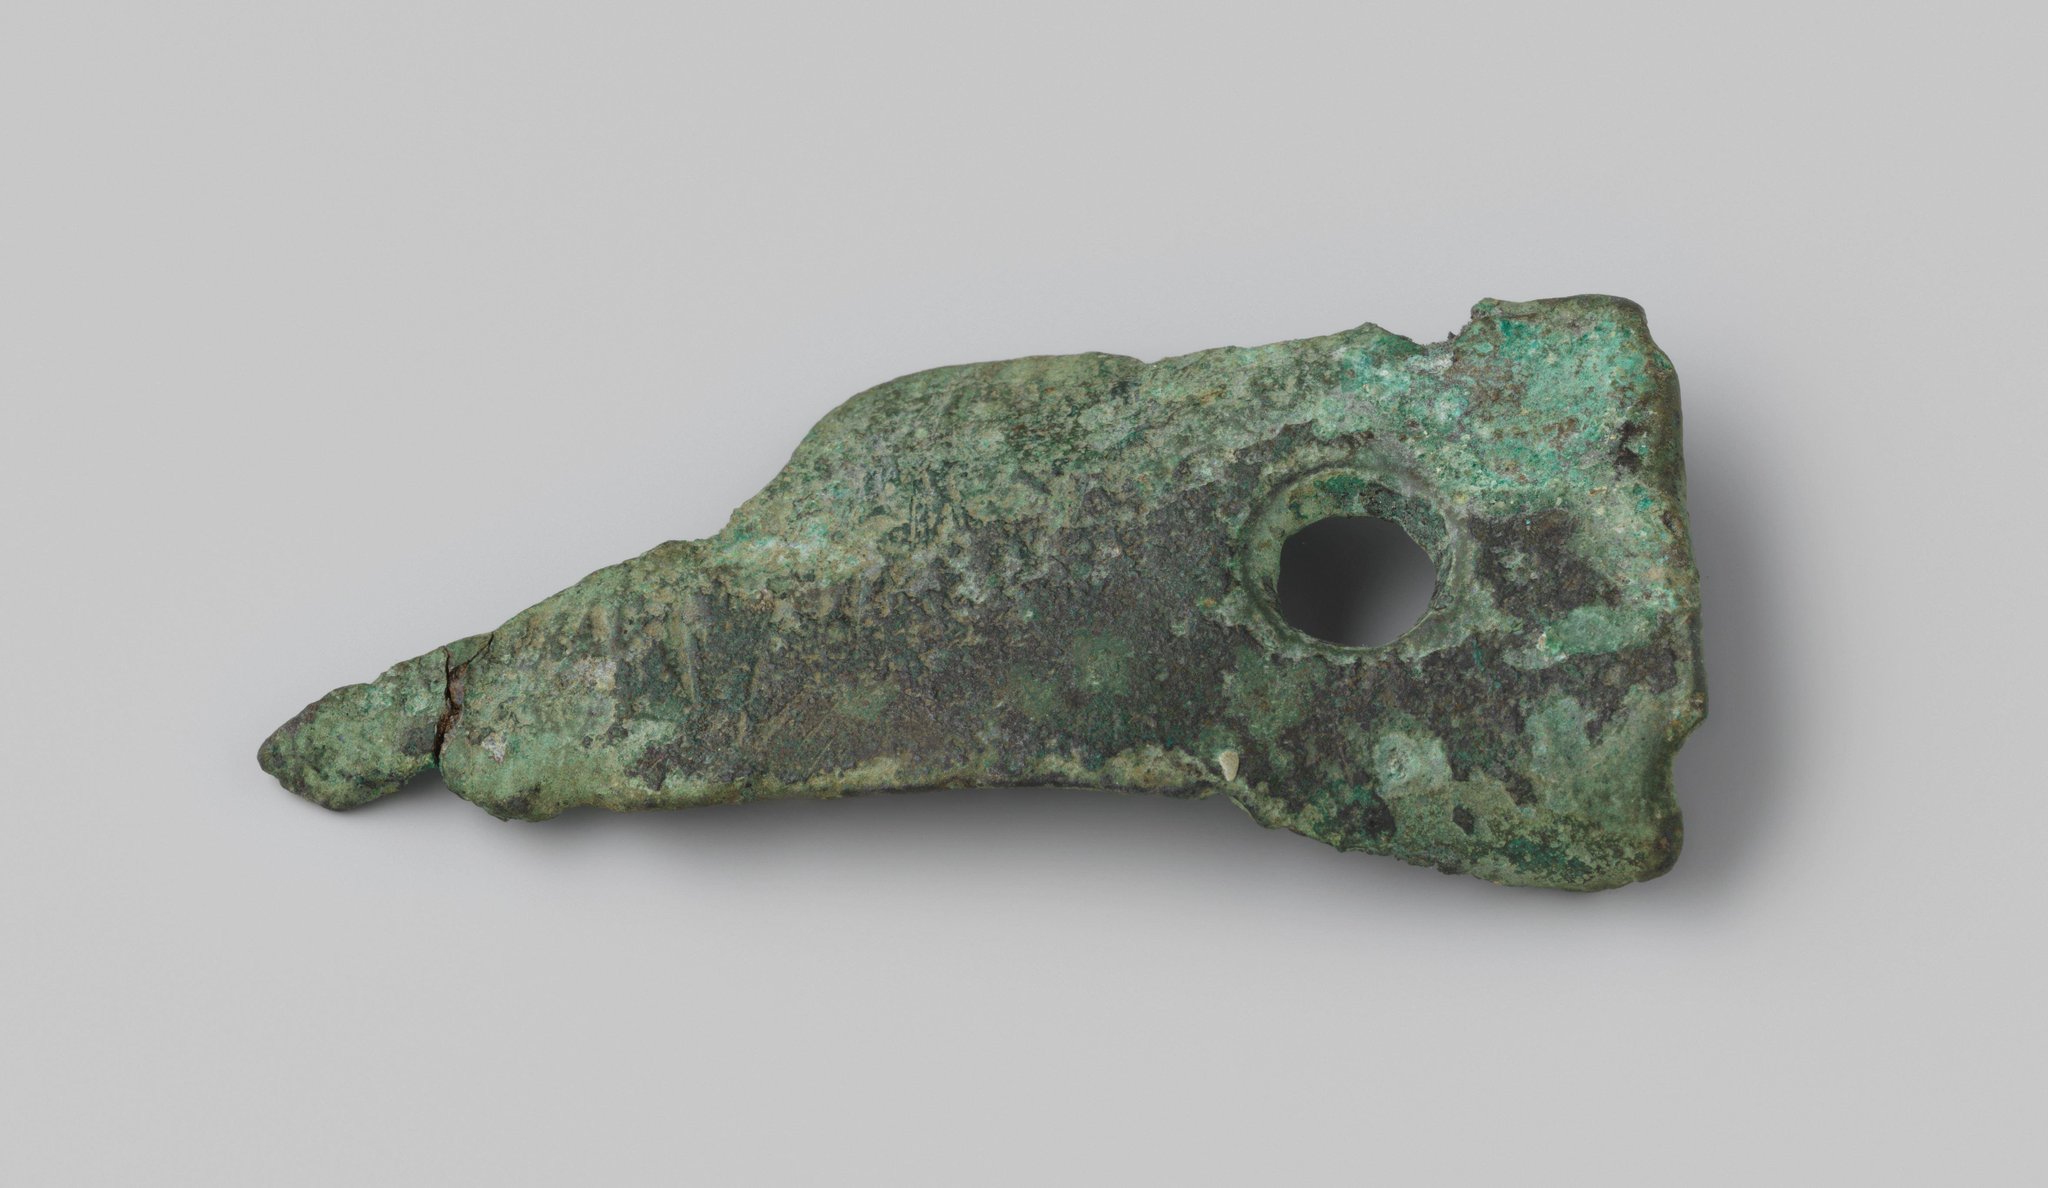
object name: part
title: Onderdeel of hulpstuk afkomstig uit het wrak van de Oost-Indiëvaarder Hollandia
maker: Anonymous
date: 1700-1743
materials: copper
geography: netherlands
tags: verenigde oostindische compagnie, hollandia (schip)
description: Strip-shaped fitting; fragm, eroded, sim 80H1670.